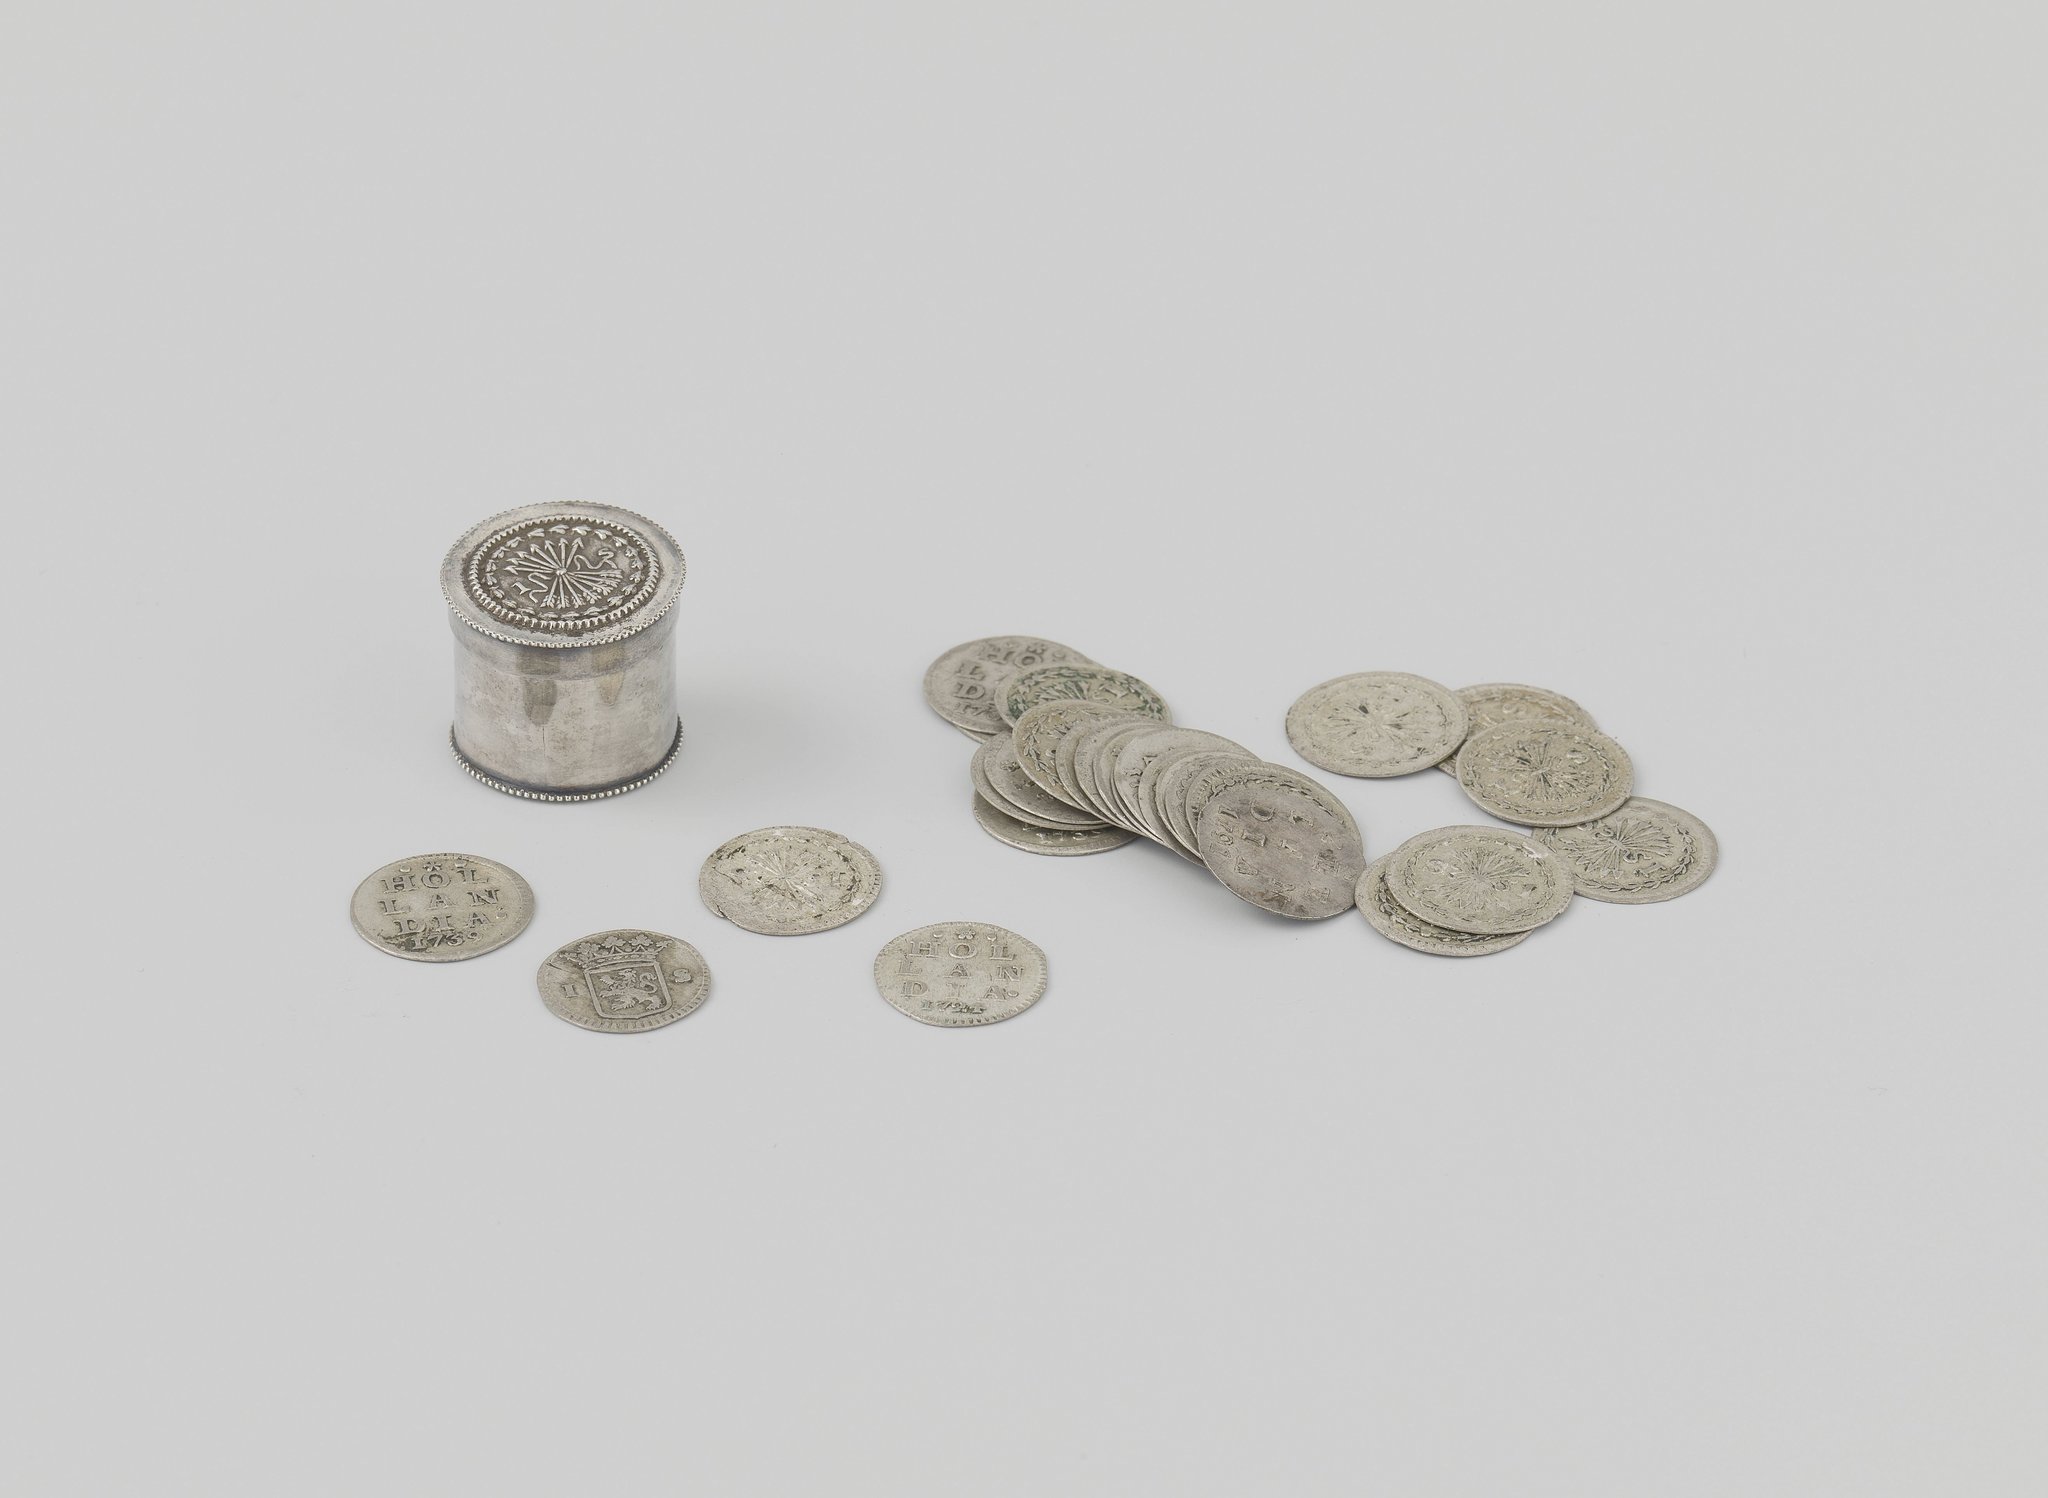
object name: miniature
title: Bus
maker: Anonymous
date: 1815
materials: silver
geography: netherlands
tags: container of precious metal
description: Gladde cilindrische bus met deksel. Op het deksel is versierd met een bundel van 7 pijlen en de letters 1 S. Op de onderzijde van de bus staat het opschrift: HOLLANDIA 1815. In de bus zitten 27 stuivers die zijn gedateerd van 1724 tot 1791. De bus is gemerkt: tweemaal een zwaardje.